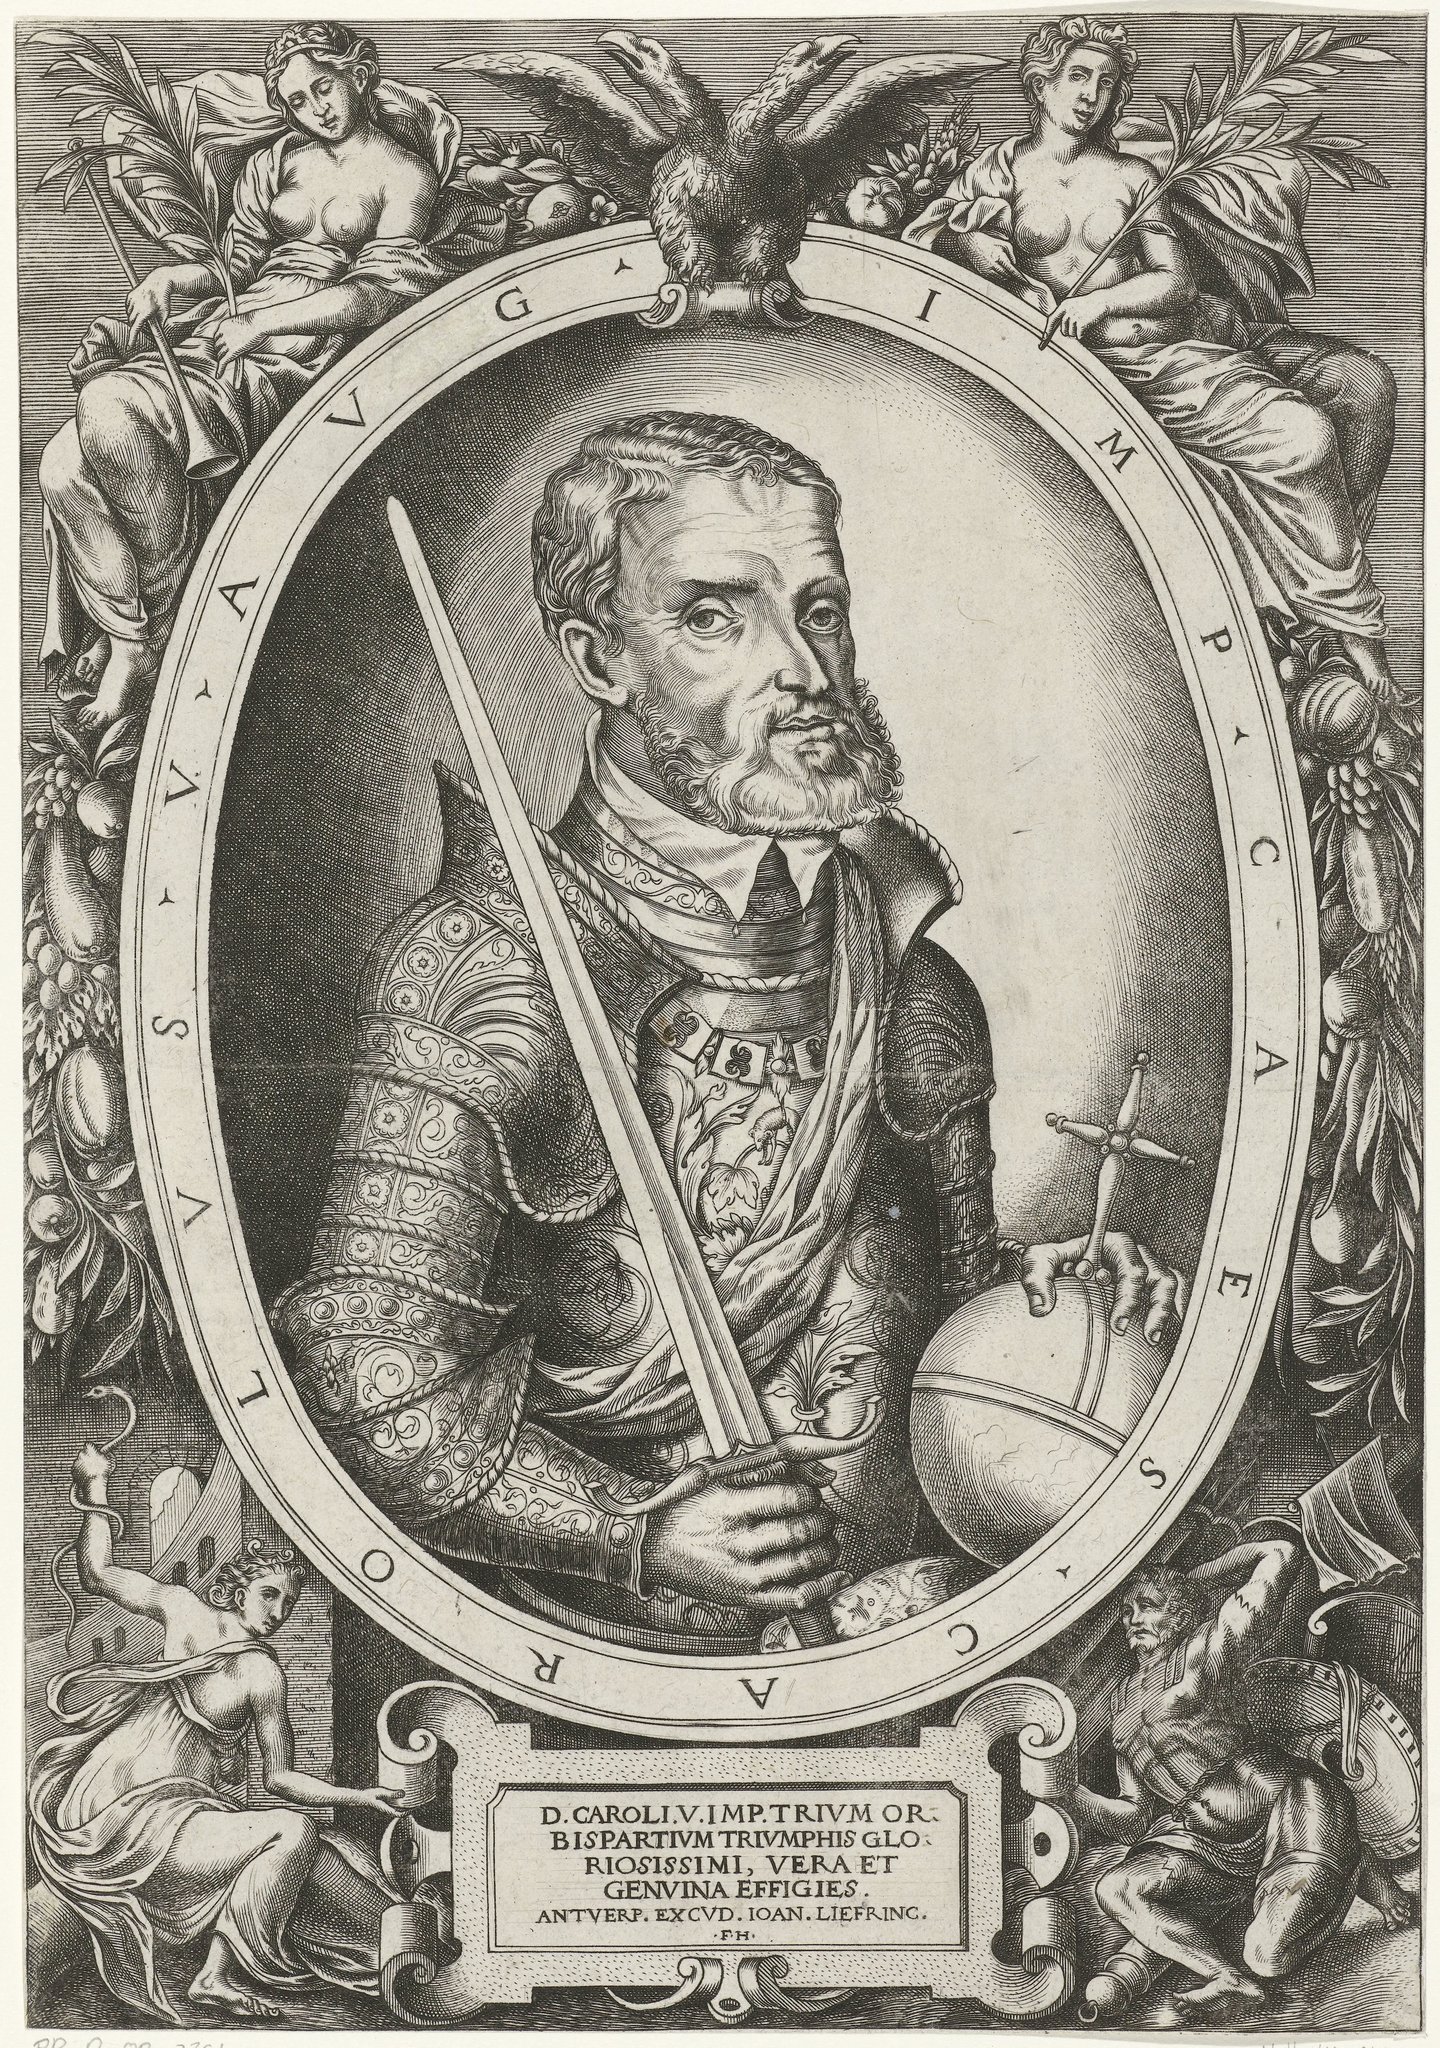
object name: print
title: Portret van keizer Karel V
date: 1546-1562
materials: paper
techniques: engraving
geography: antwerp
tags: ghent, charles v (holy roman emperor and king of spain)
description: Buste van Karel V van Habsburg, Duits keizer, koning van Spanje, naar rechts in een ovale lijst met randschrift in het Latijn. Zijn linkerhand rust op een rijksappel, in zijn rechterhand houdt hij een zwaard. Boven het portret een tweekoppige adelaar. Rechts en linksboven de Faam met trompet en de Overwinning met palmtak. Linksonder een vrouw met een slang in haar hand, rechtsonder een geketende man. Onder het portret een plaquette met vierregelige tekst in het Latijn.